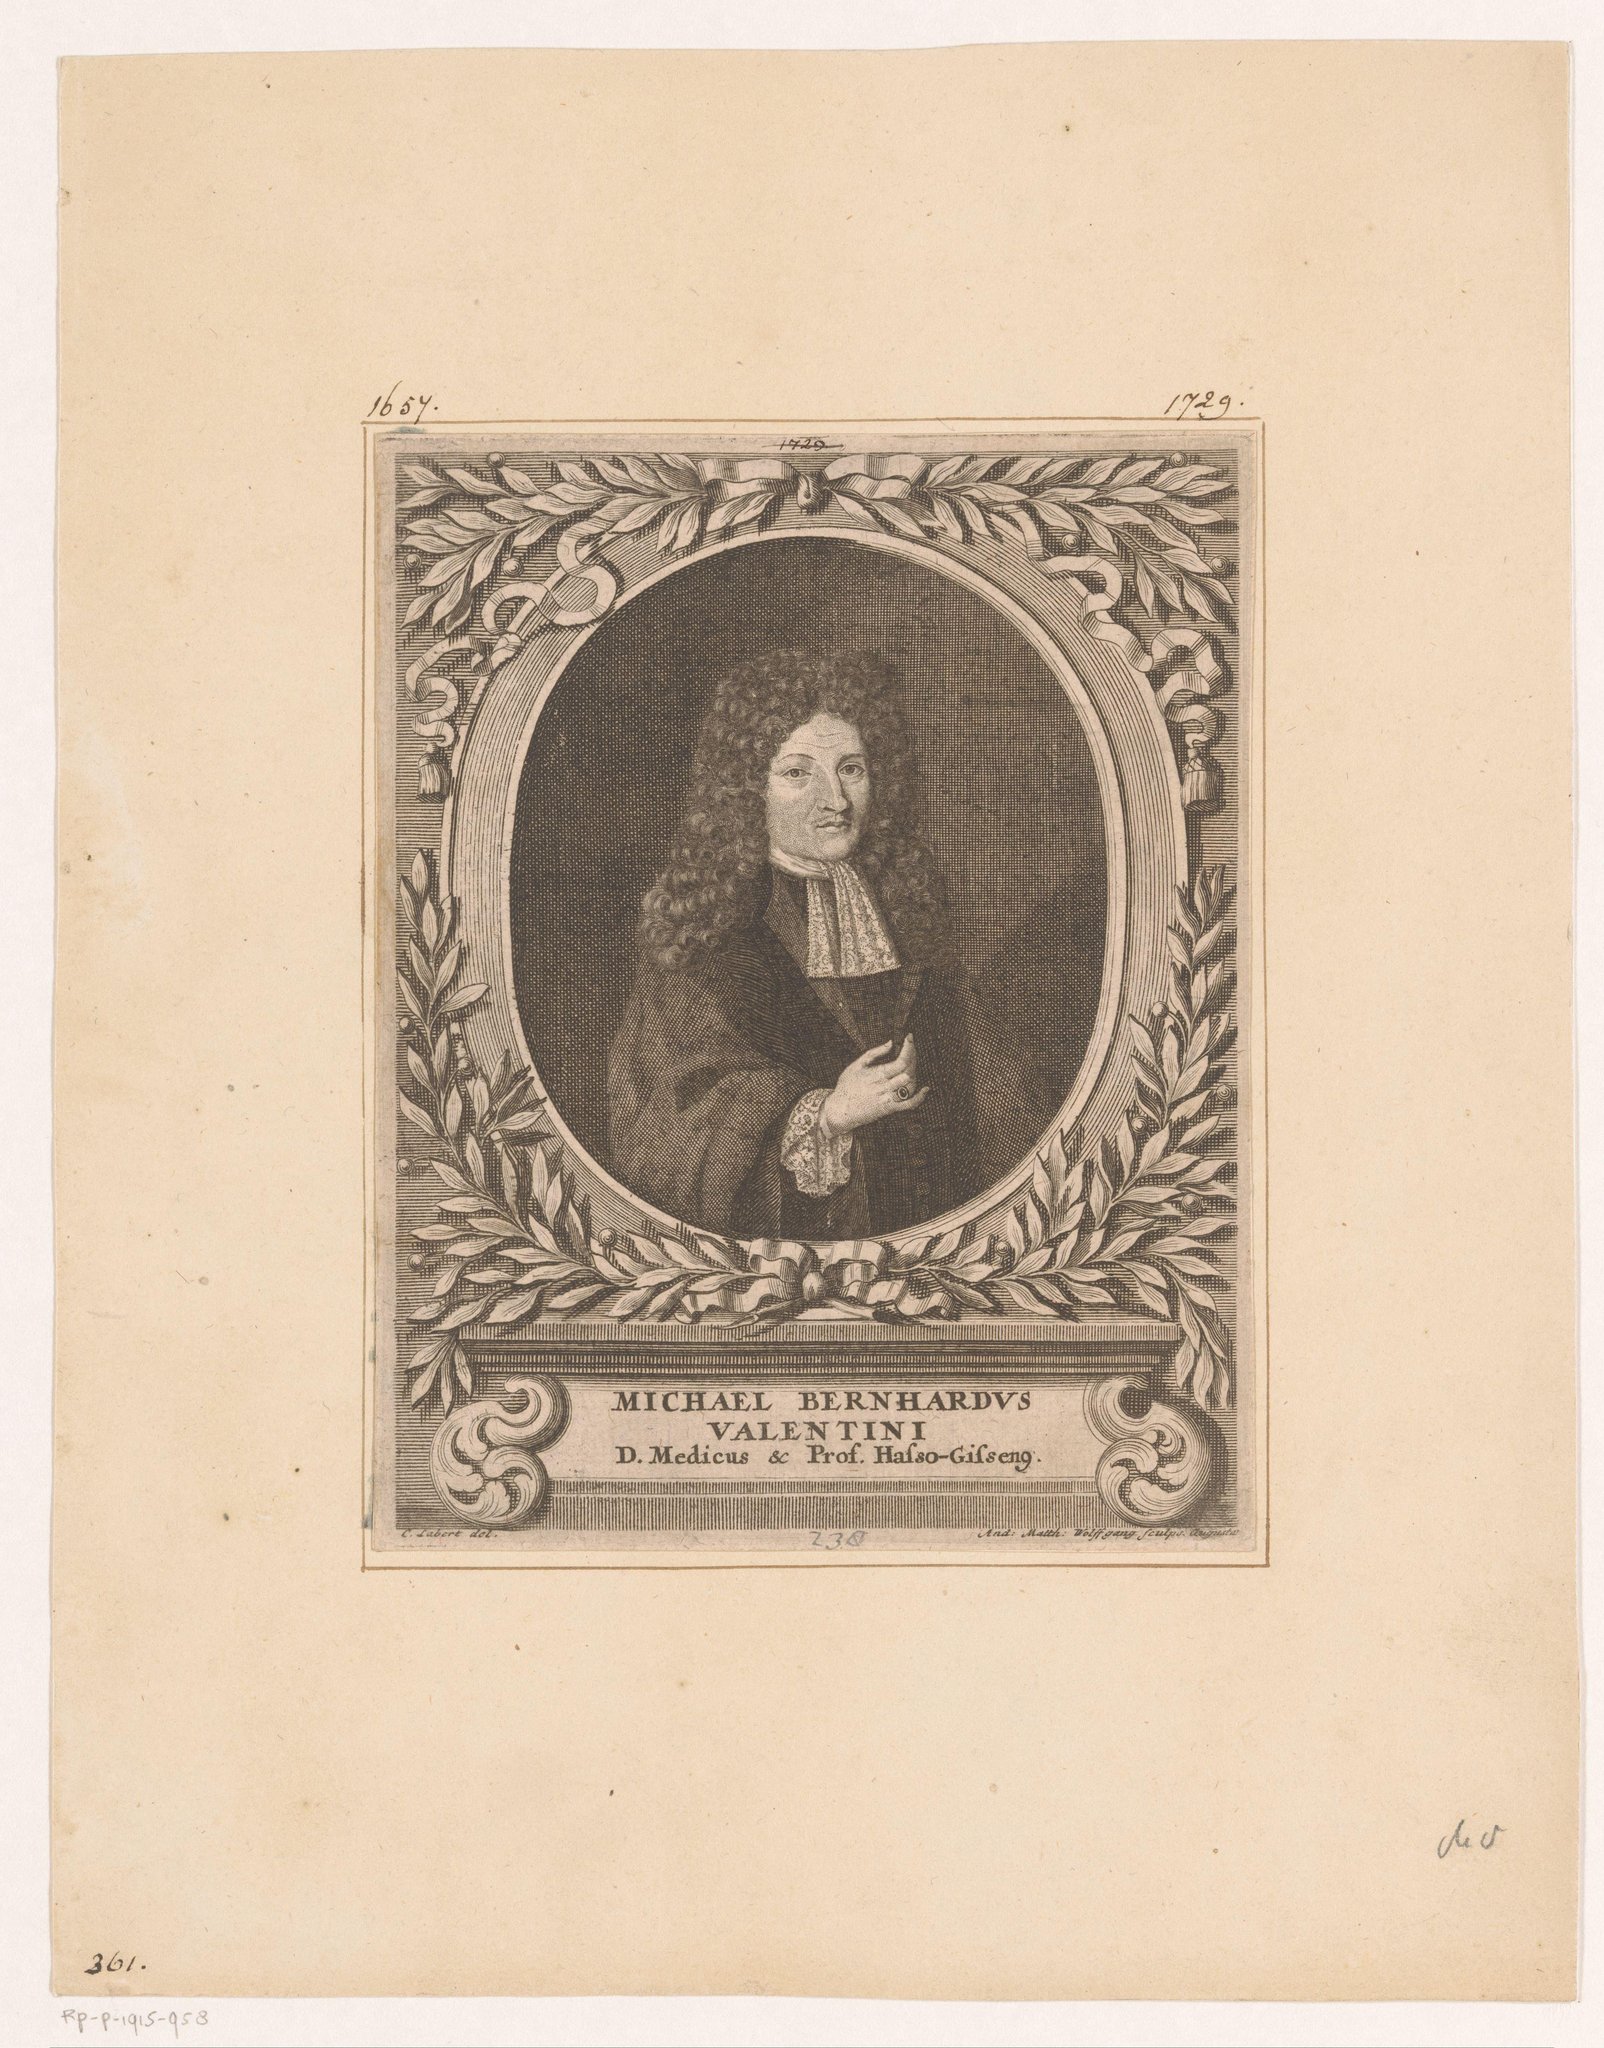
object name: print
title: Portret van Michael Bernhard Valentini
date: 1700-1737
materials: paper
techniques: engraving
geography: augsburg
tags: historical persons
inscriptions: number: ‘361.’, inscription: ‘1657/ 1729’, collector's mark: Lugt 2228